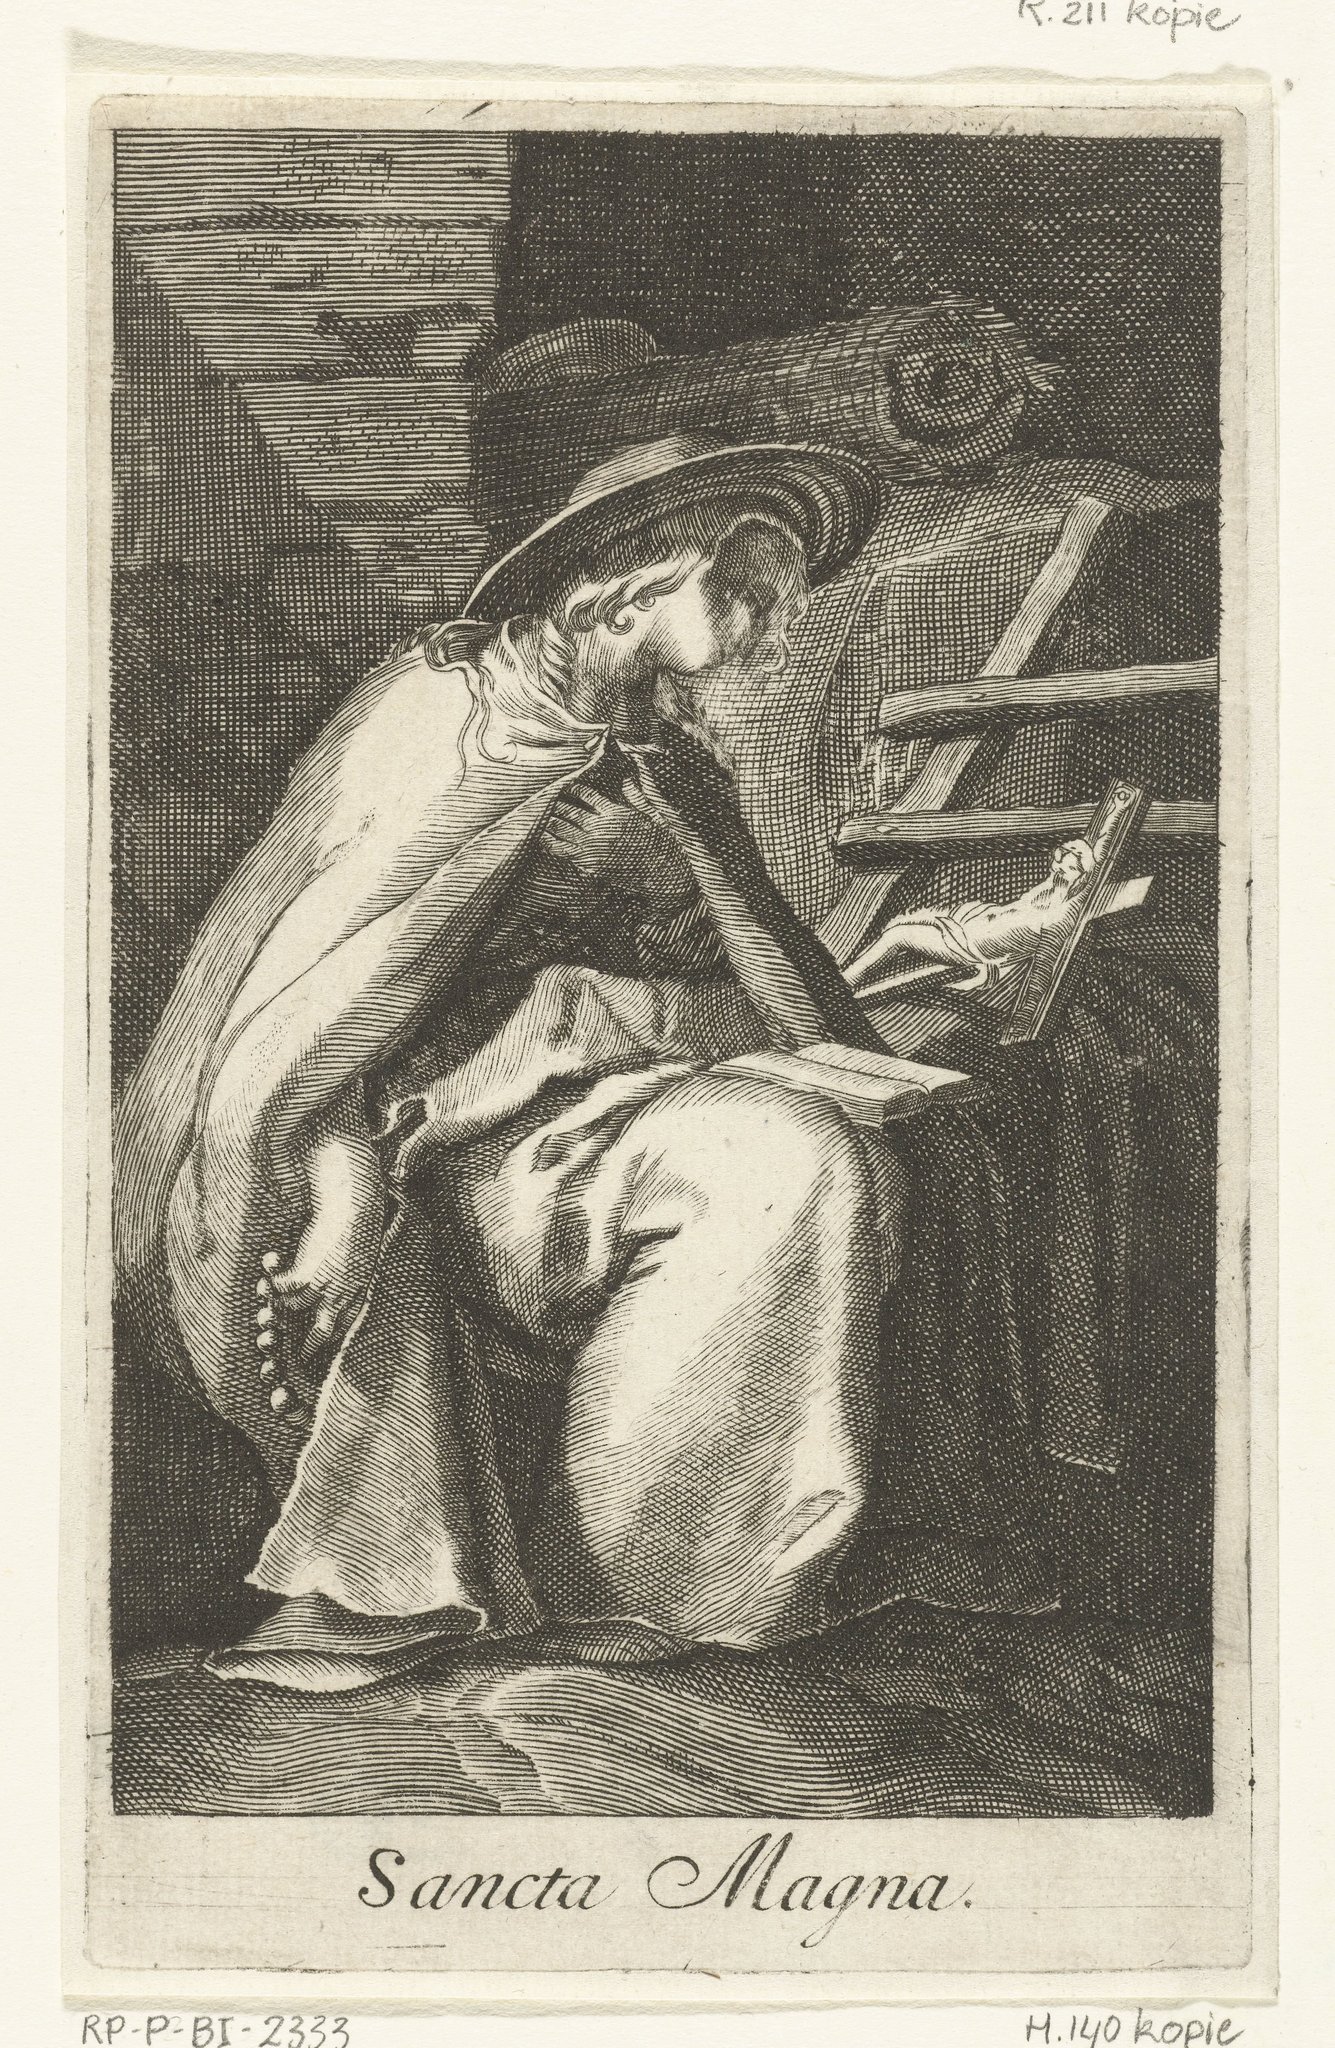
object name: print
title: Sacra Eremus Ascetriarum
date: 1590-1662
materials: paper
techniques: engraving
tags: anchorite, hermit, female saints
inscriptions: collector's mark: Lugt 2228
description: Kopie in spiegelbeeld naar prent van Boëtius Adamsz. Bolswert uit serie Kluizenaressen.